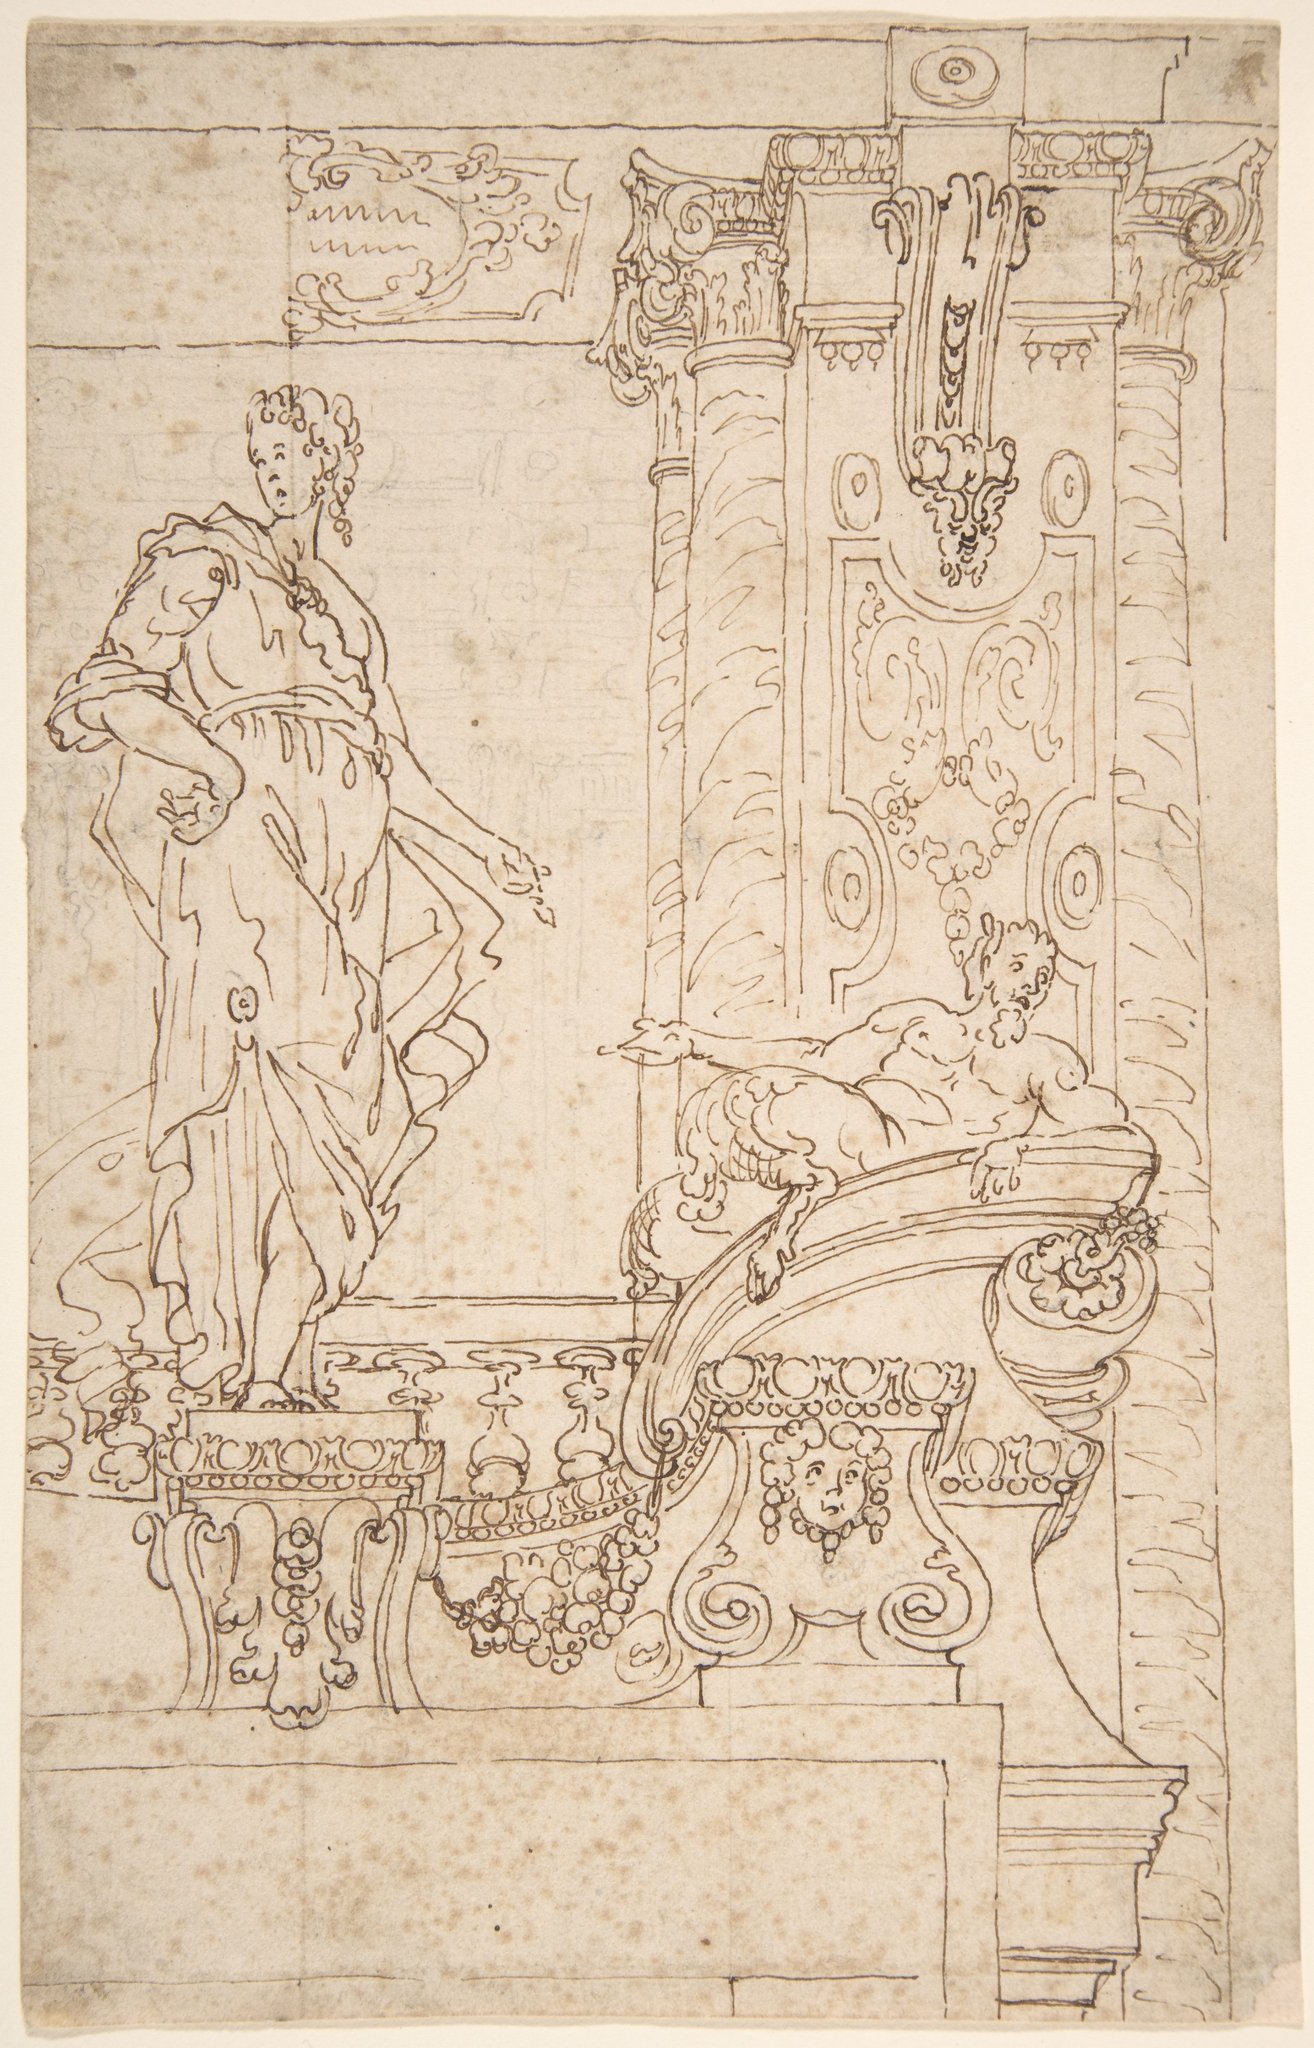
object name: drawing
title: Sketch of Balcony and Pier (?) With Standing Female and a Reclining Satyr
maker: anonymous, italian, 18th century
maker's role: artist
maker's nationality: italian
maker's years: 1700-1800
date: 1701-1800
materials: graphite, ink, lead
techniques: pen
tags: women,satyrs